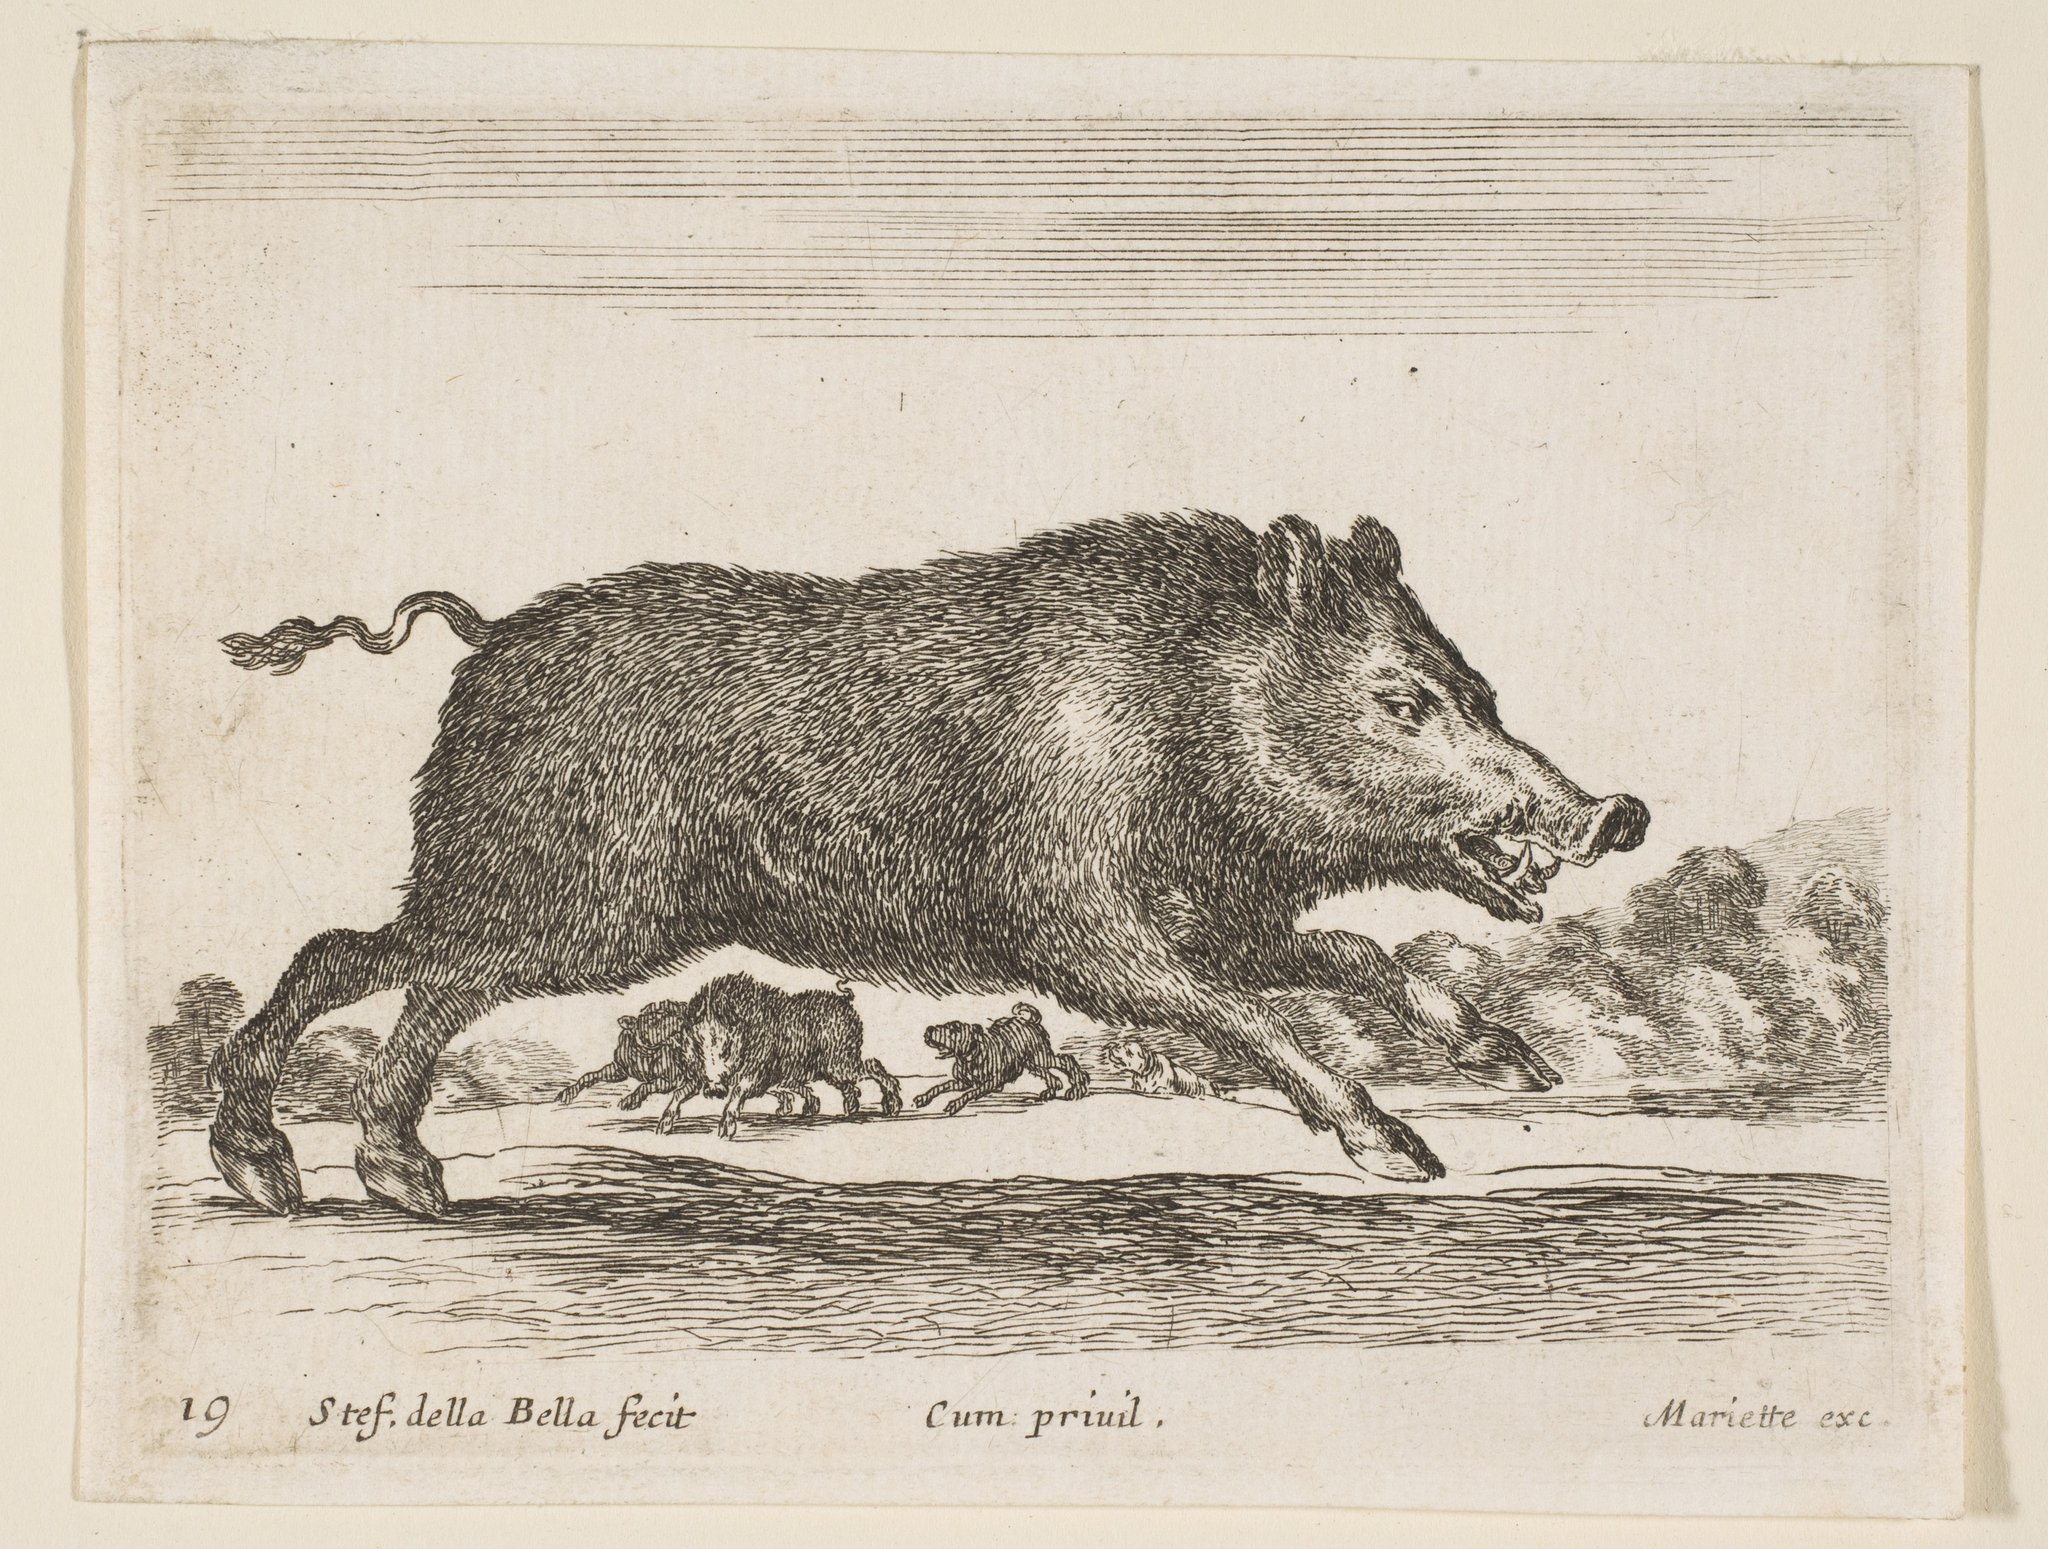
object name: print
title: Wild boar, plate 19 from "Various Animals" (Diversi Animali)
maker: stefano della bella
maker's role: artist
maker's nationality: italian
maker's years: 1610-1664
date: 1641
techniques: etching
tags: boars